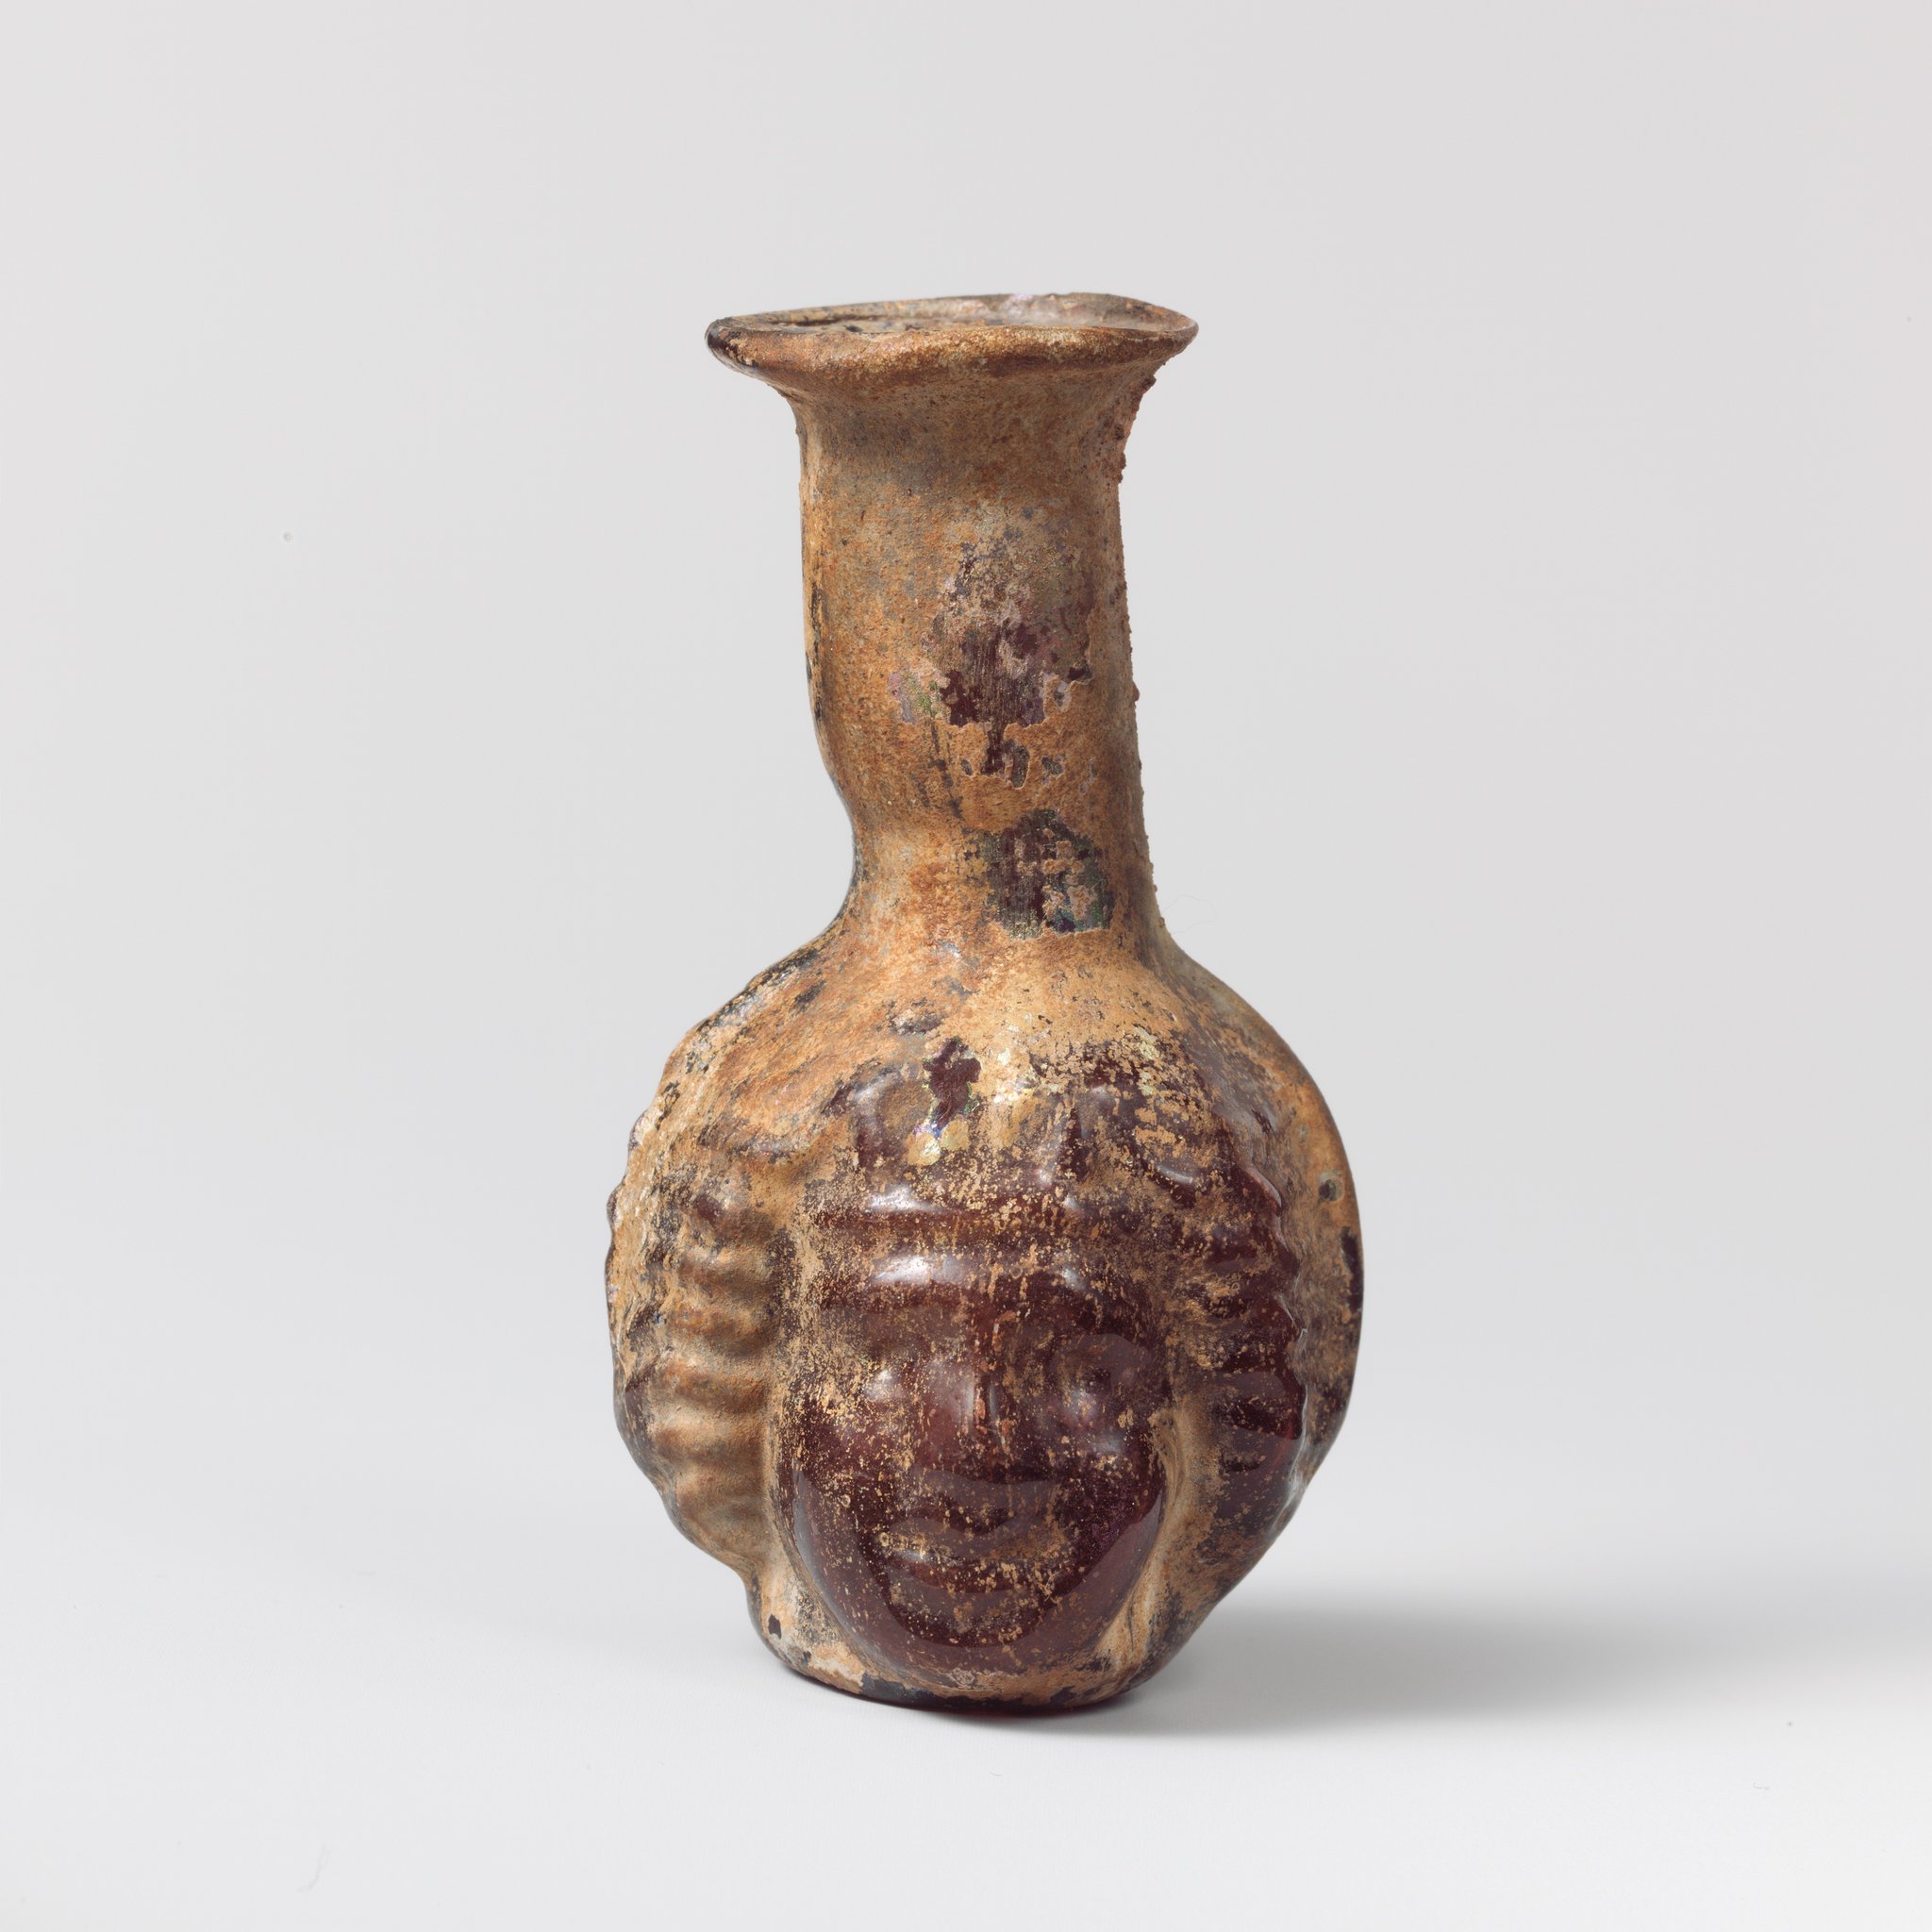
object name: bottle, double head shaped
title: Glass double head-shaped bottle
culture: roman, syrian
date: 101-200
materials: glass